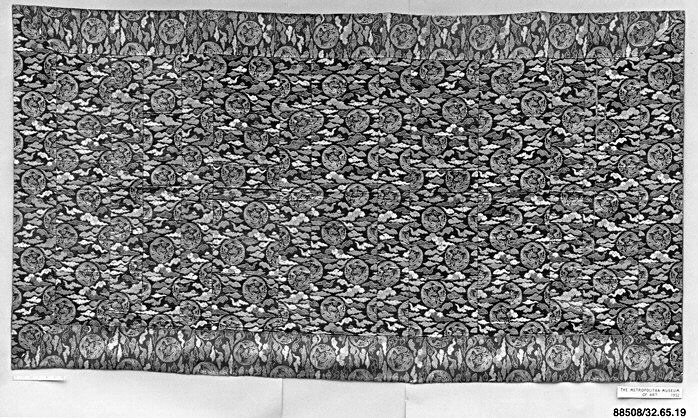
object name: robe, priest's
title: Priest's Robe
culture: japanese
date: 1701-1900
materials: metal thread, silk